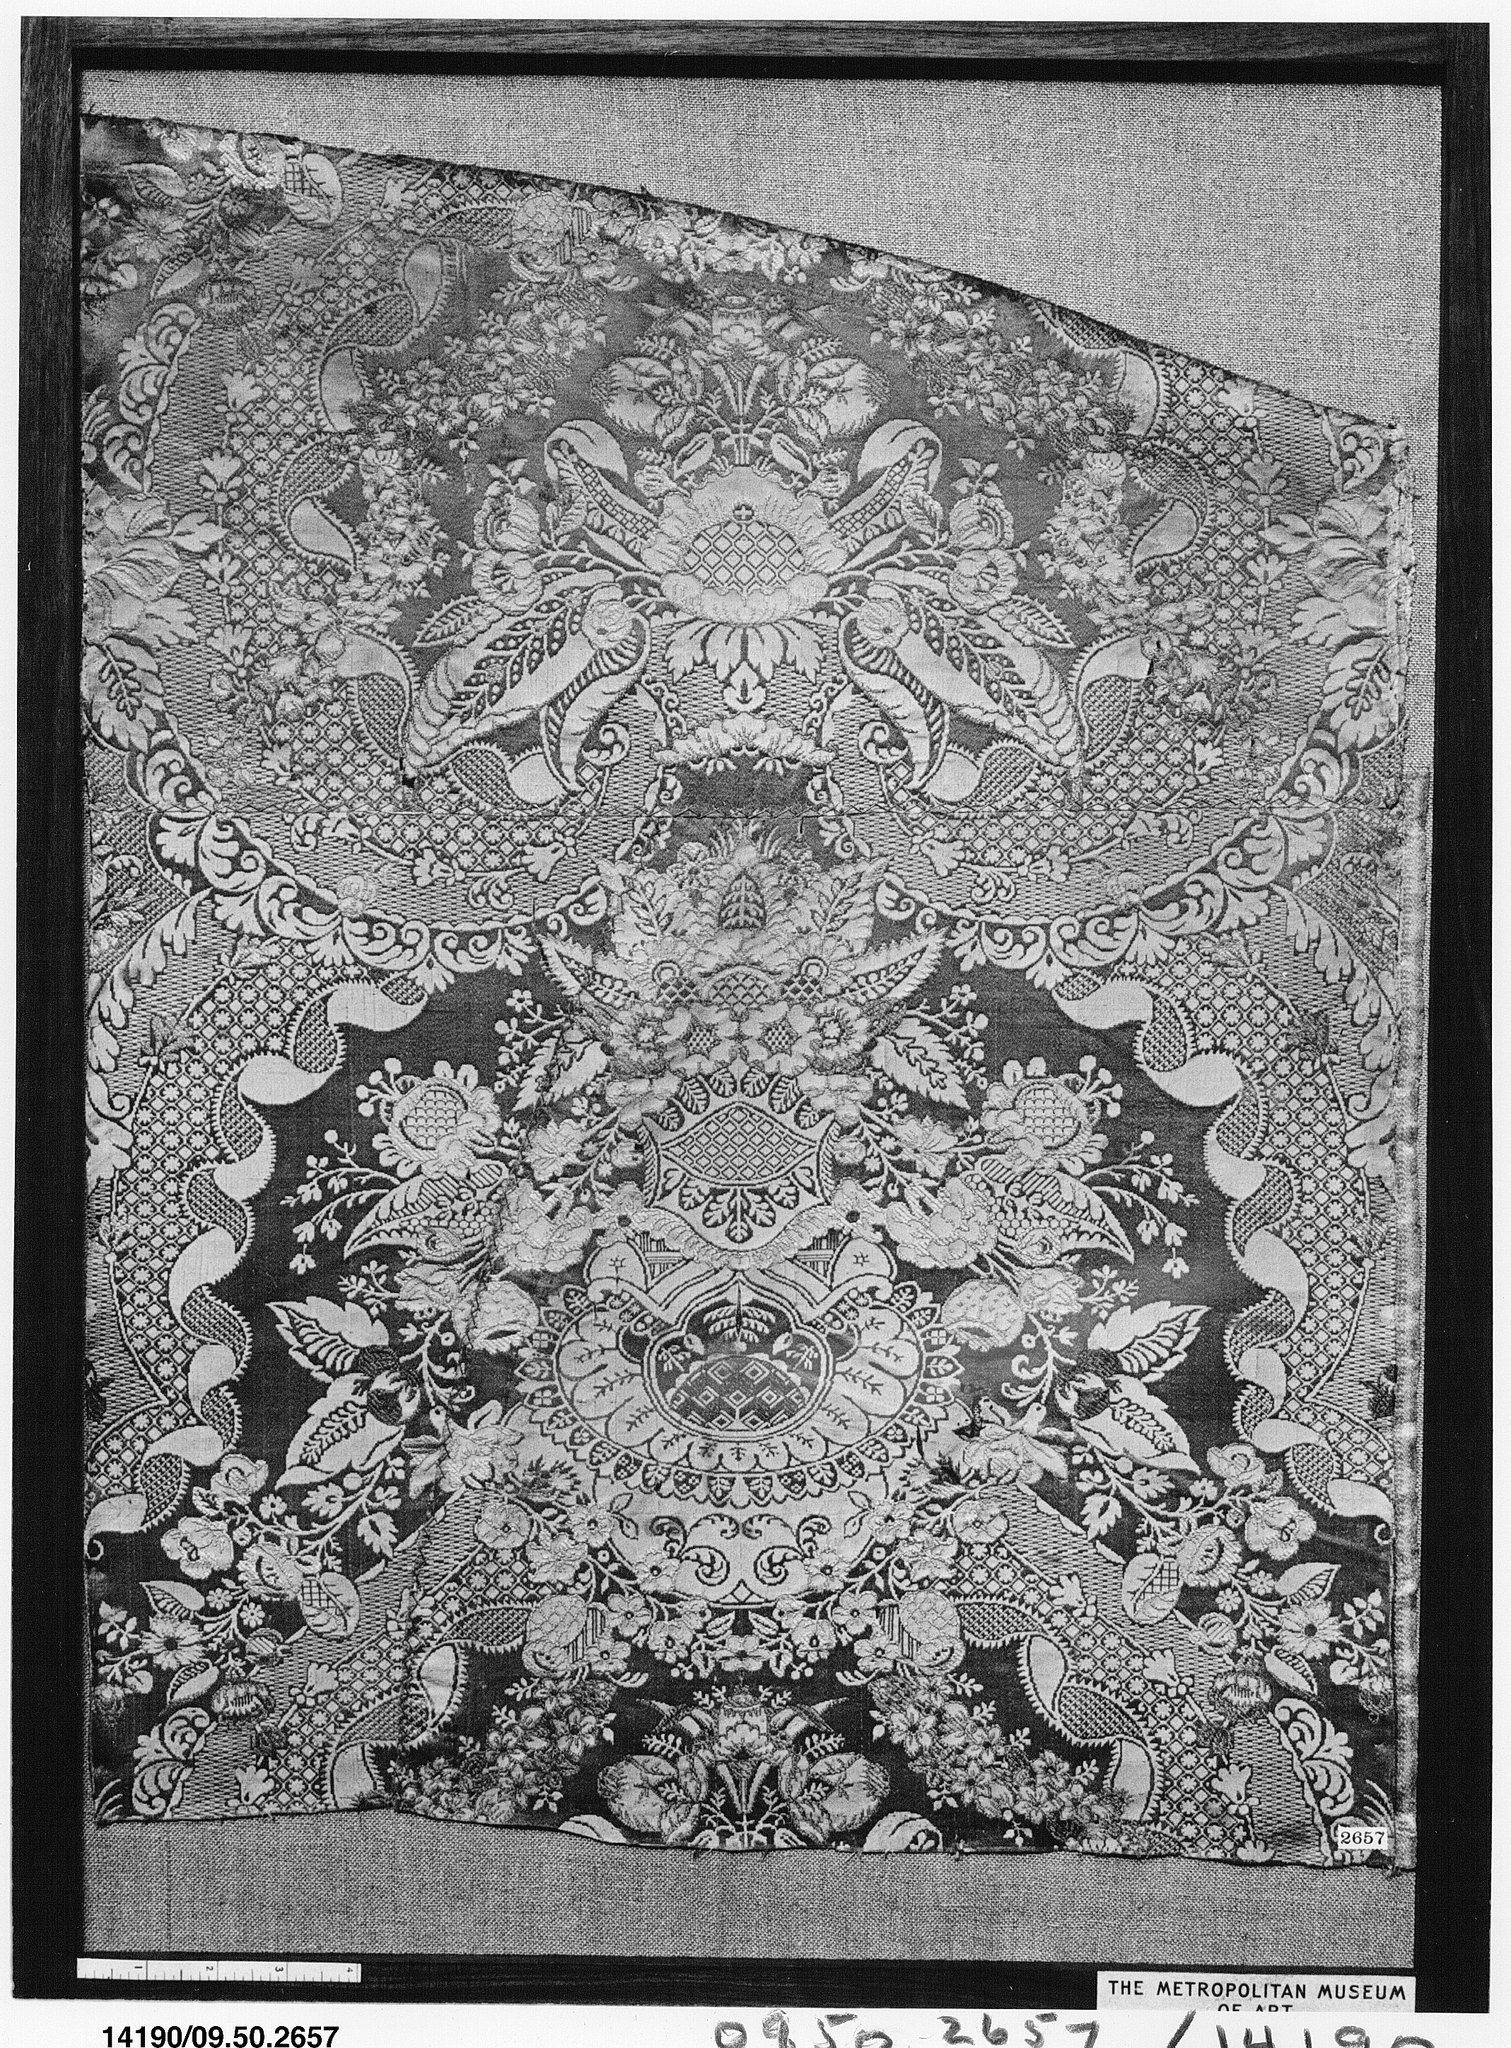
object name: piece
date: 1720-1725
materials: silk